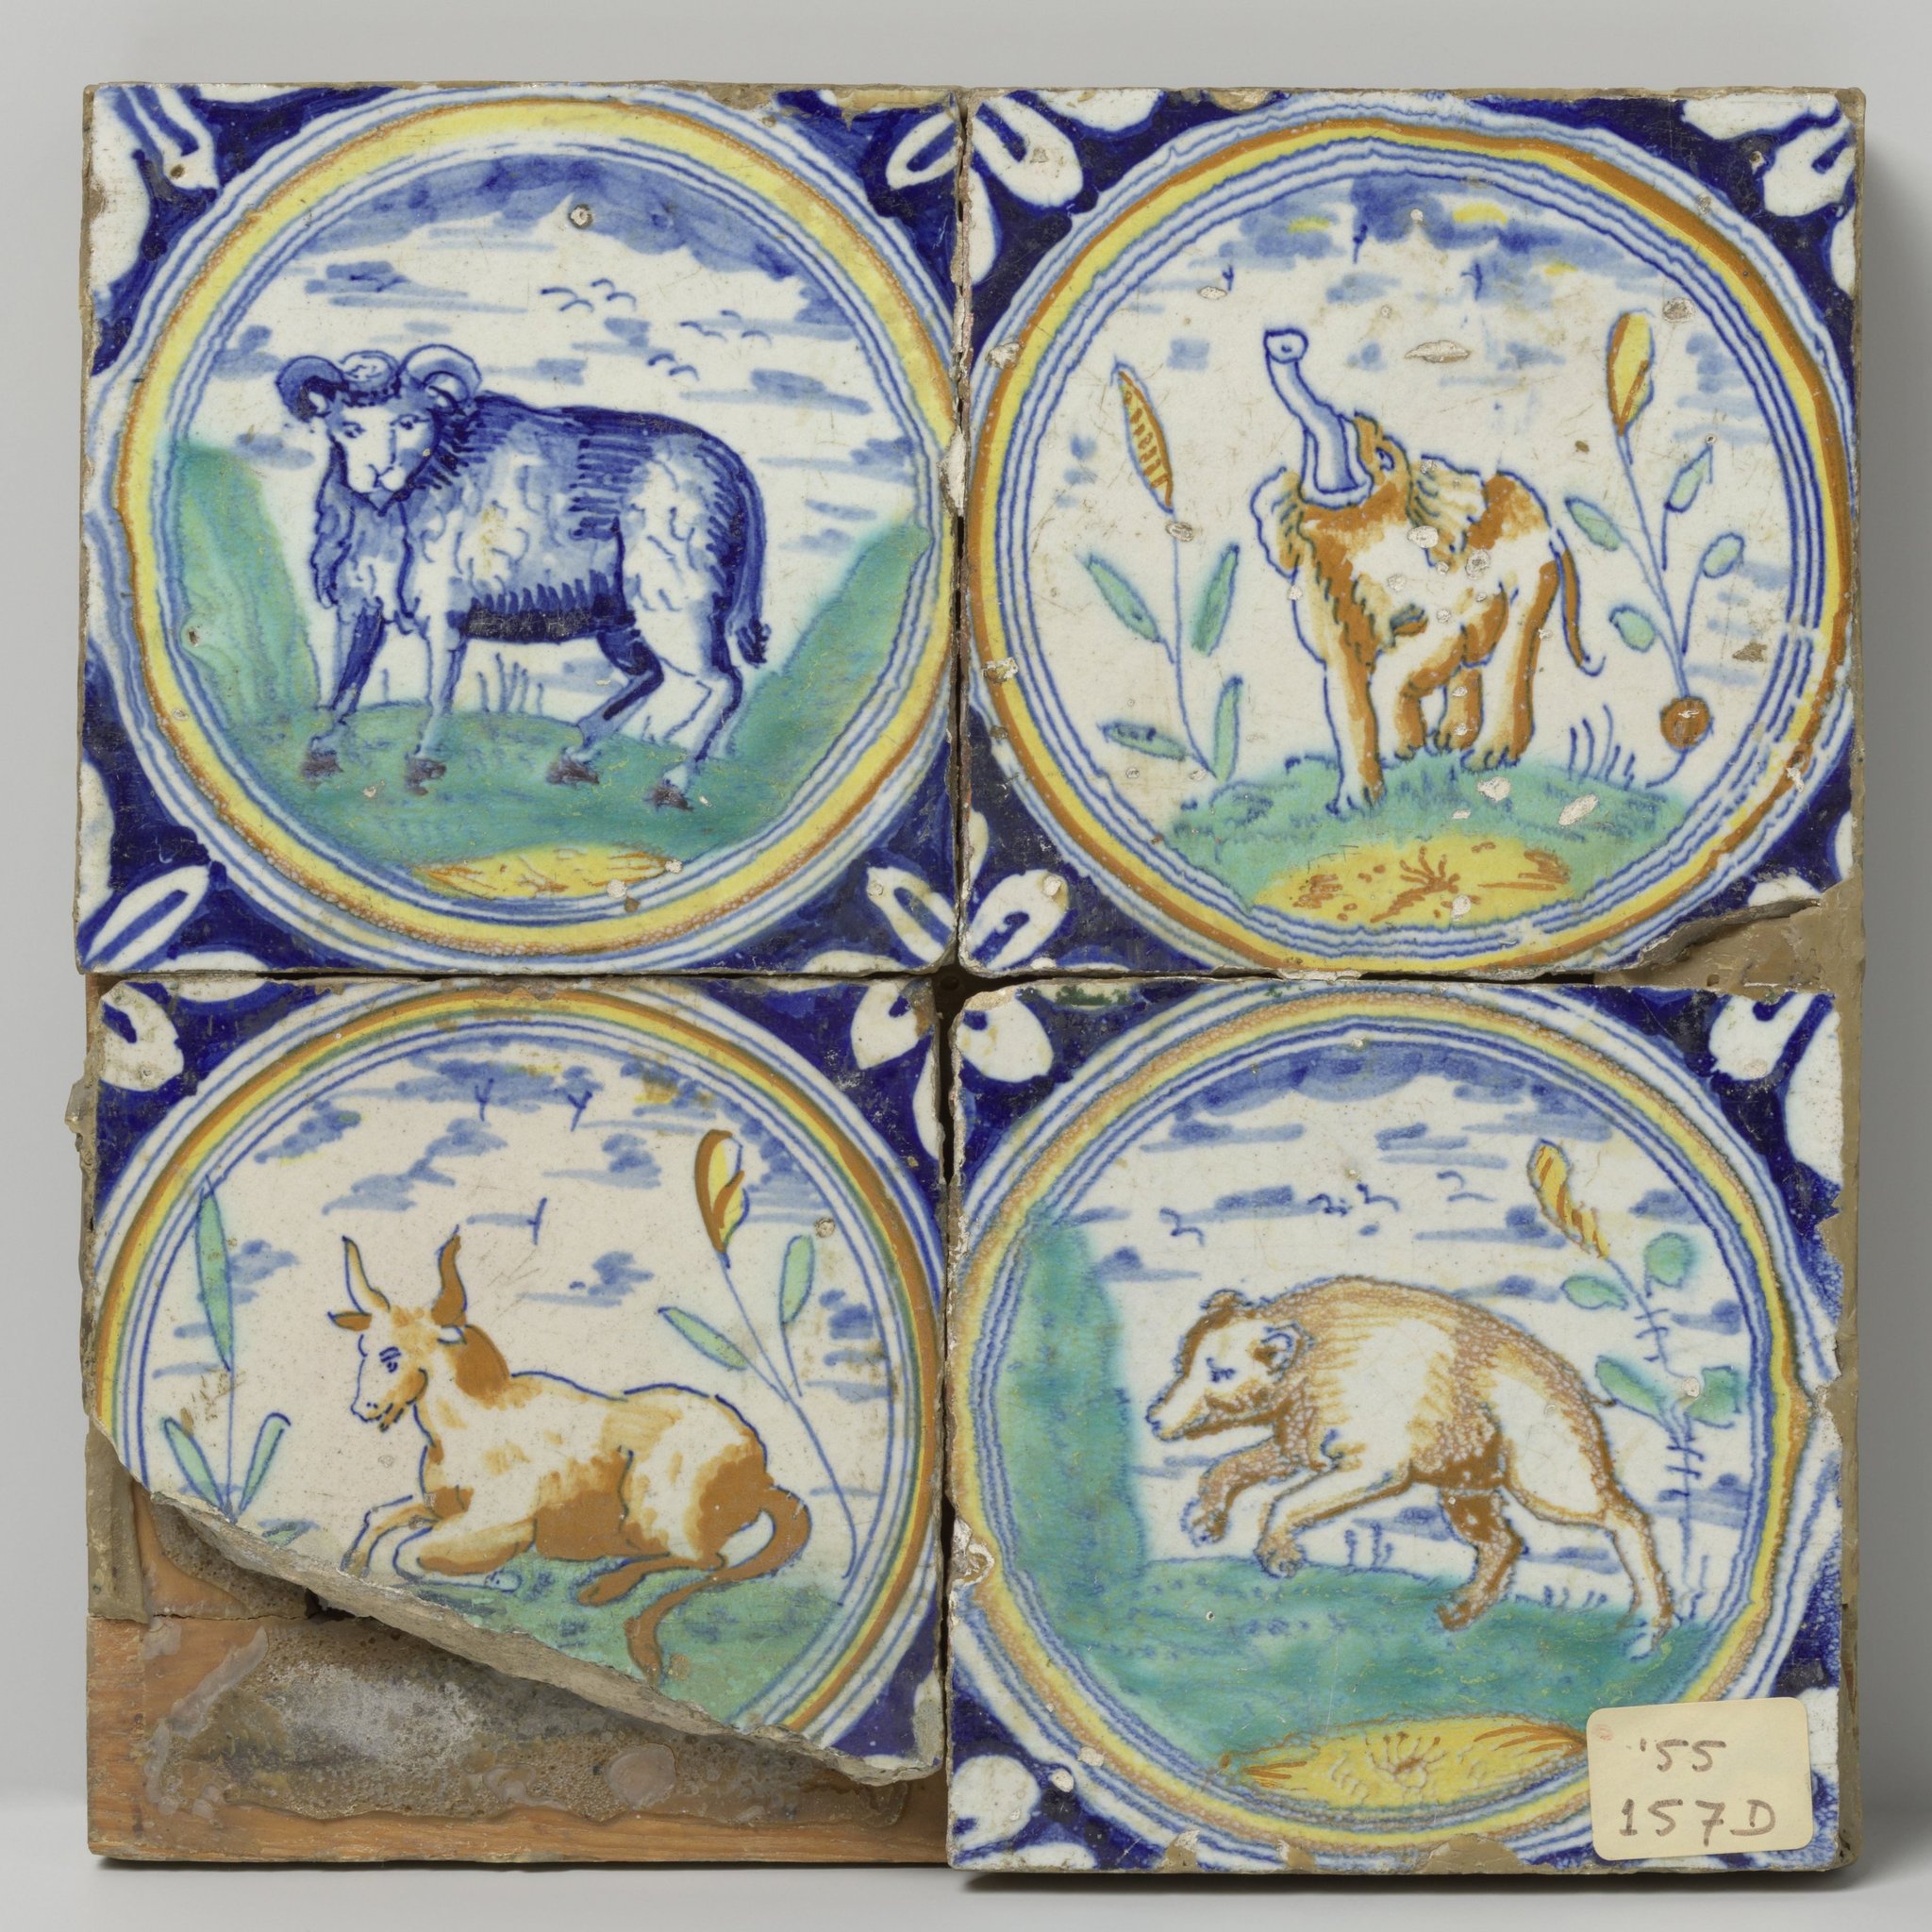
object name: tegelveld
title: Veld van vier tegels met dieren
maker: Anonymous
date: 1580-1625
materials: earthenware, glaze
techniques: maiolica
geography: netherlands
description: Veld van vier tegels elk met een veelkleurig (blauw, oranje, groen, geel en paars) dier op een grond binnen een cirkel omlijsting. In de hoeken, vultechniek ornament.